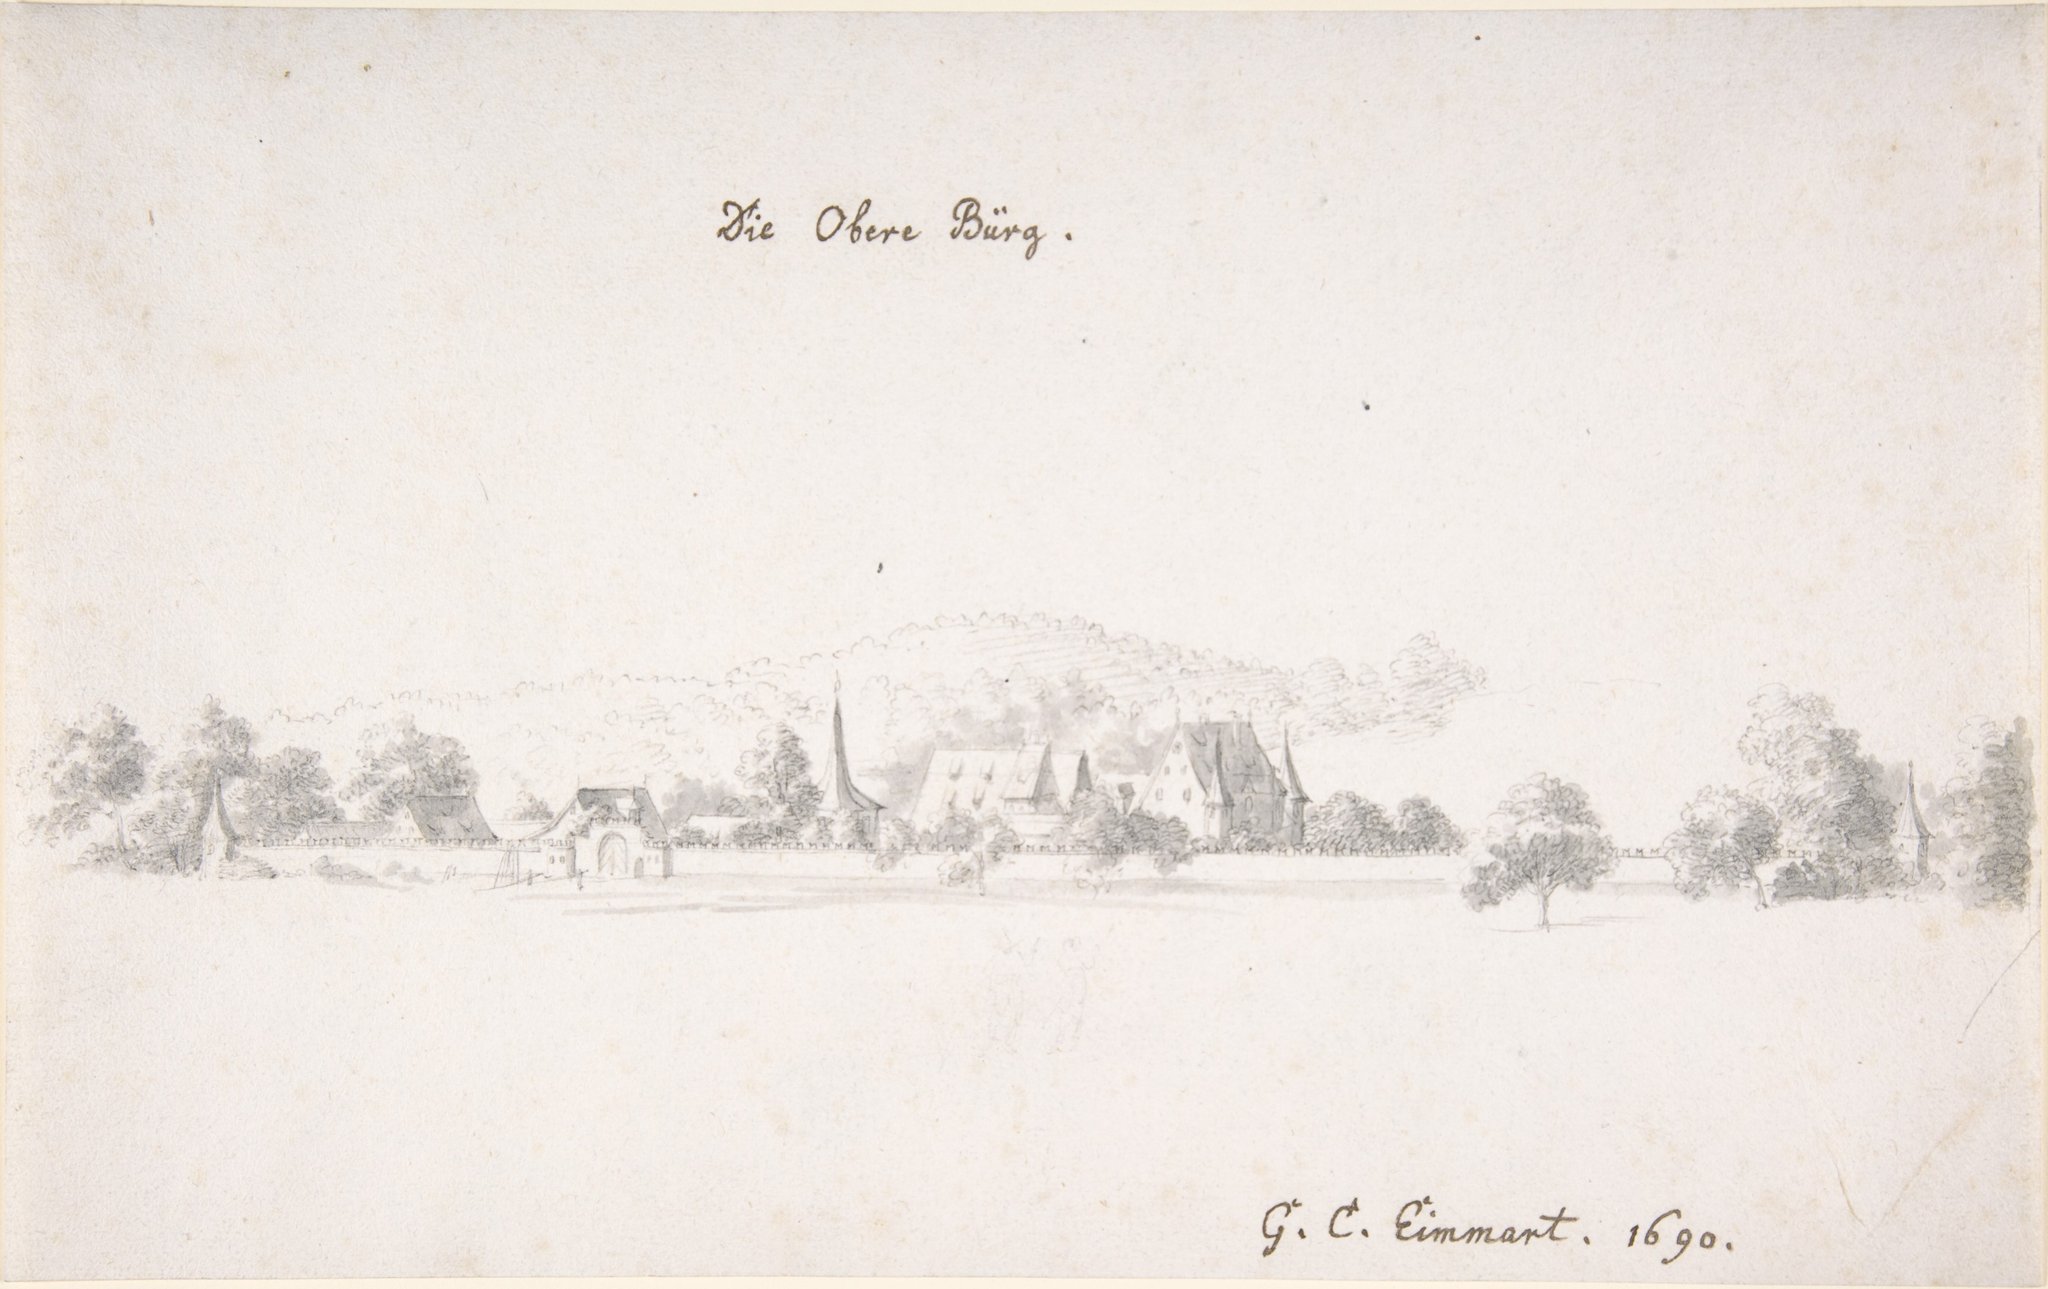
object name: drawing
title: View of the castle at Oberbürg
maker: georg christoph eimmart the younger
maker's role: artist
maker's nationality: german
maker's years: 1638-1705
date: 1690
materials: graphite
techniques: wash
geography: germany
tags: castles,trees